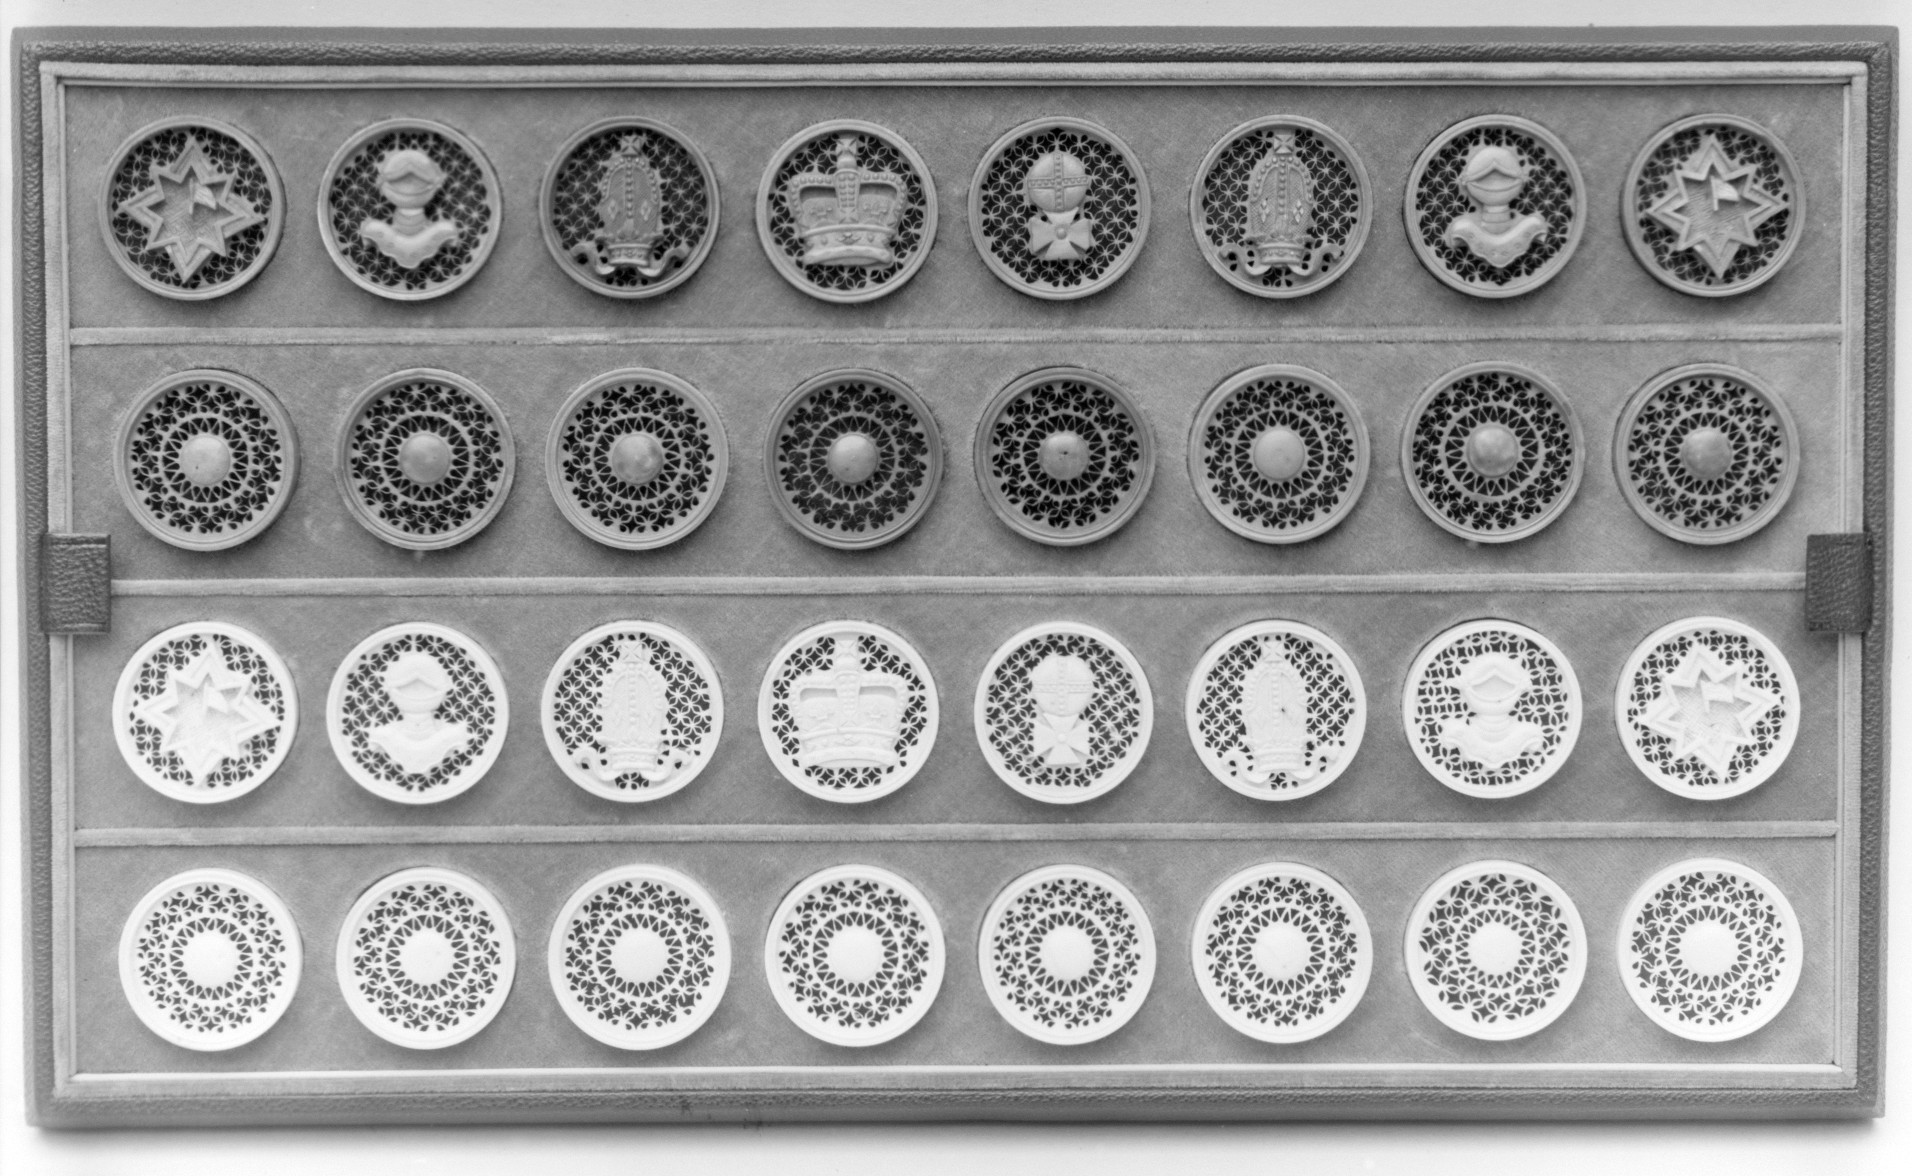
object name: chessman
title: Chessmen (32)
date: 1801-1900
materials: ivory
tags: chess,games